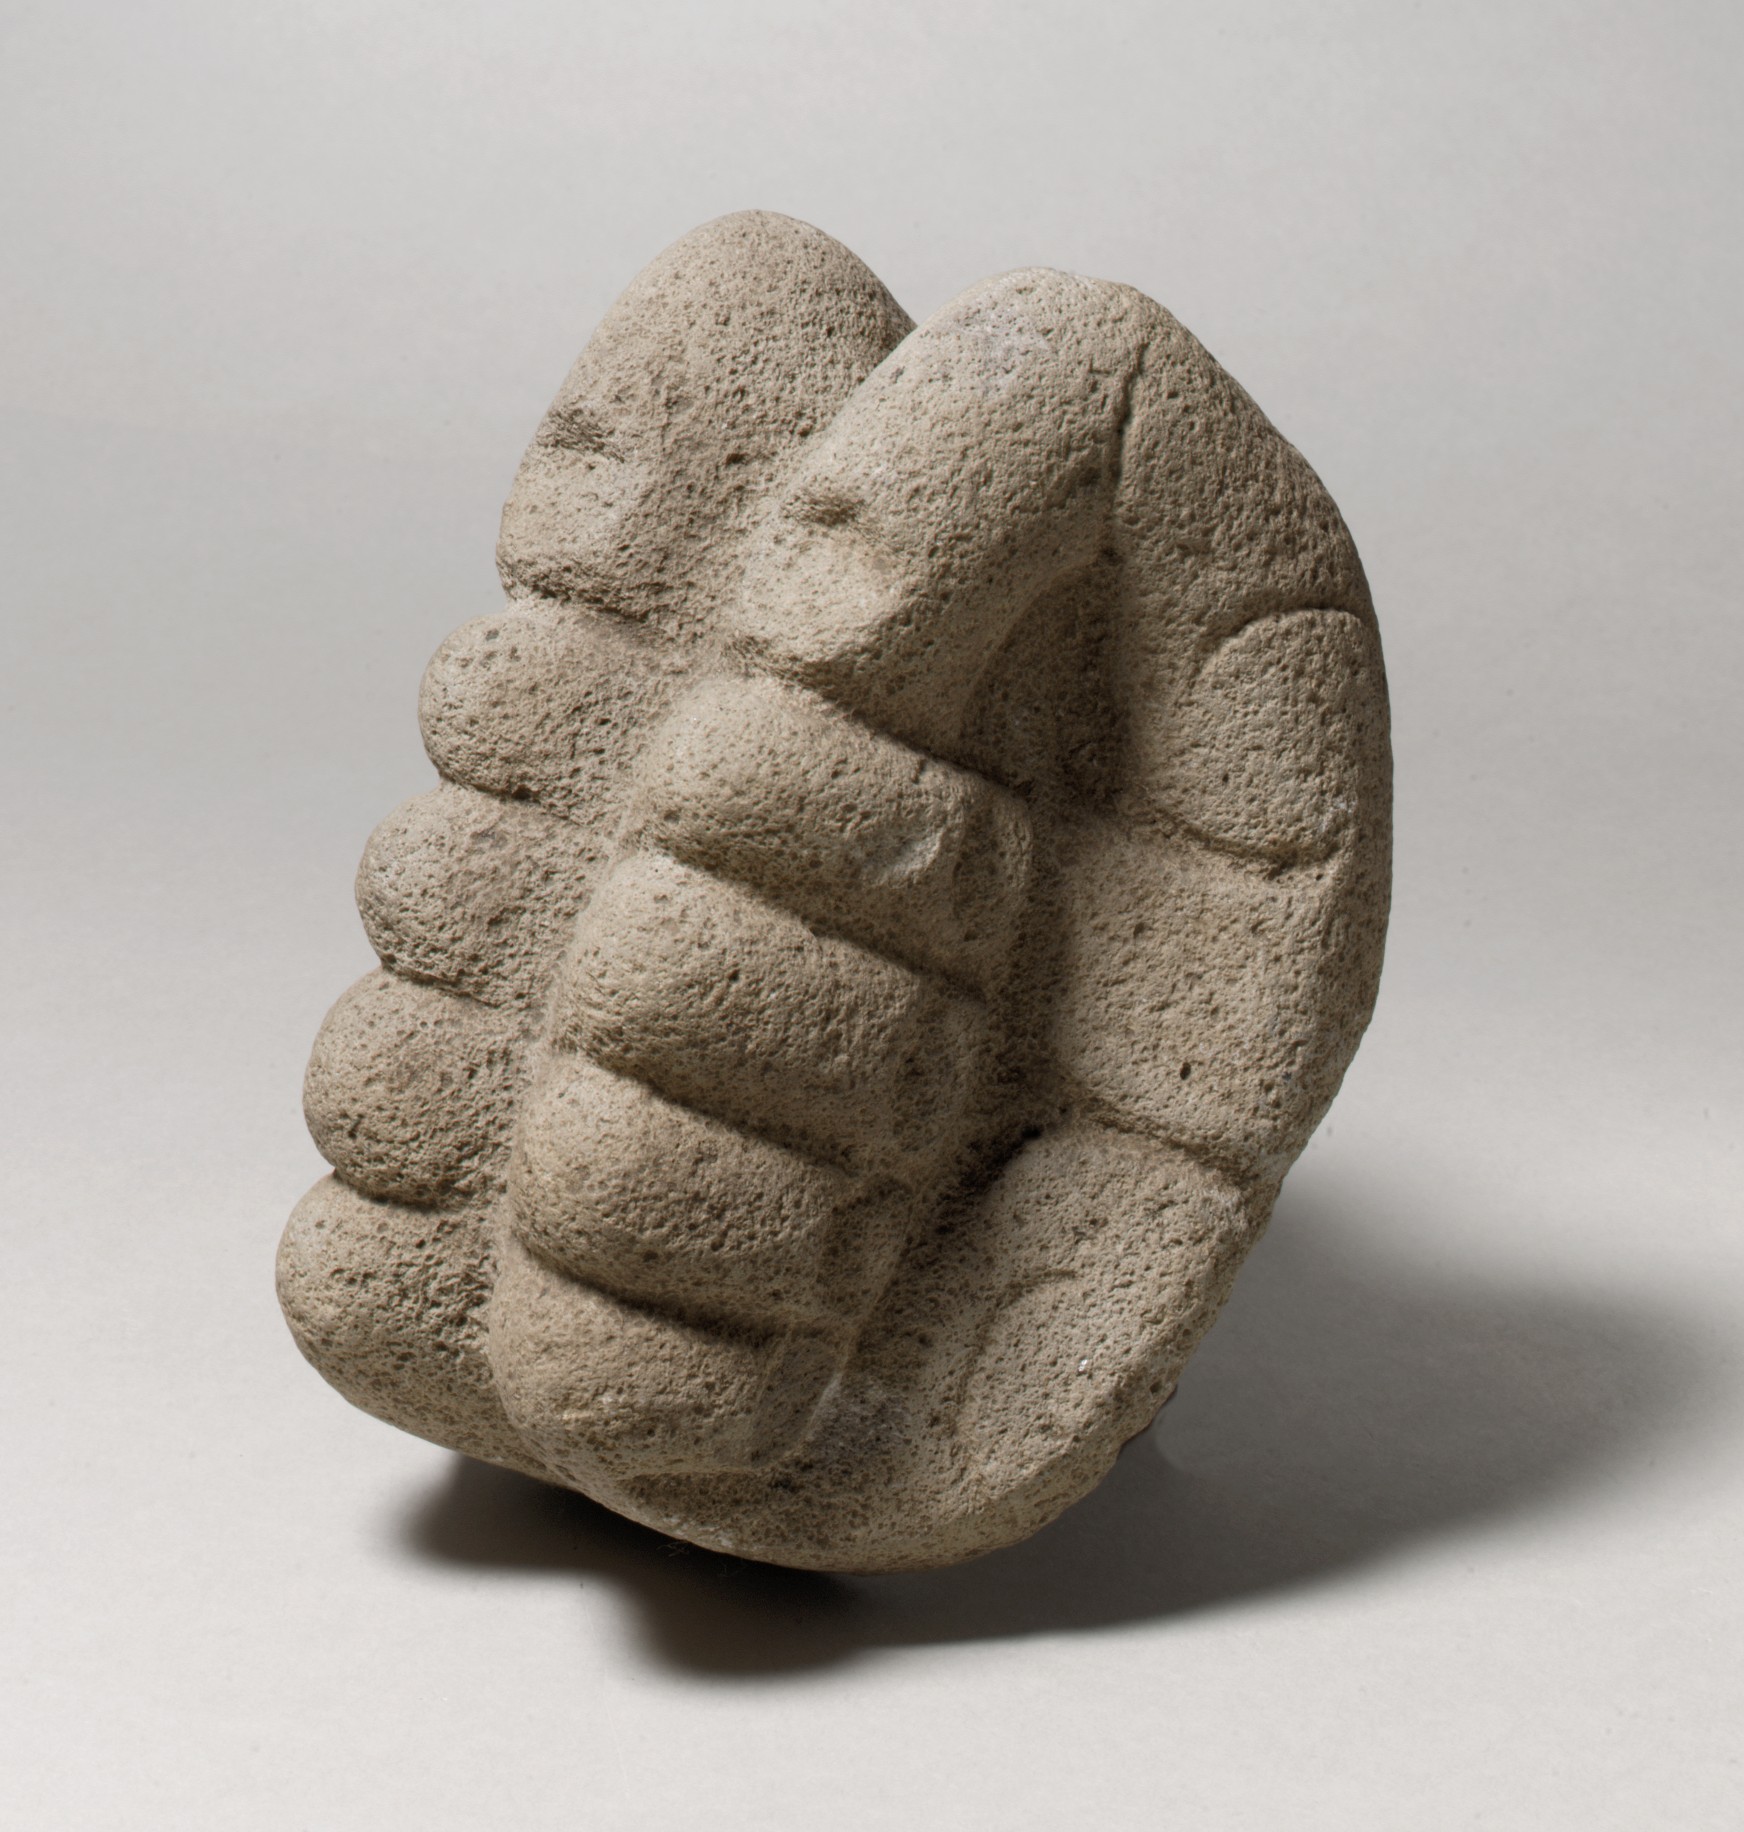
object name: hacha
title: Bound-hands hacha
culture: veracruz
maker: classic veracruz artist(s)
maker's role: artist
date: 600-900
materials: stone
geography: mexico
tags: hands